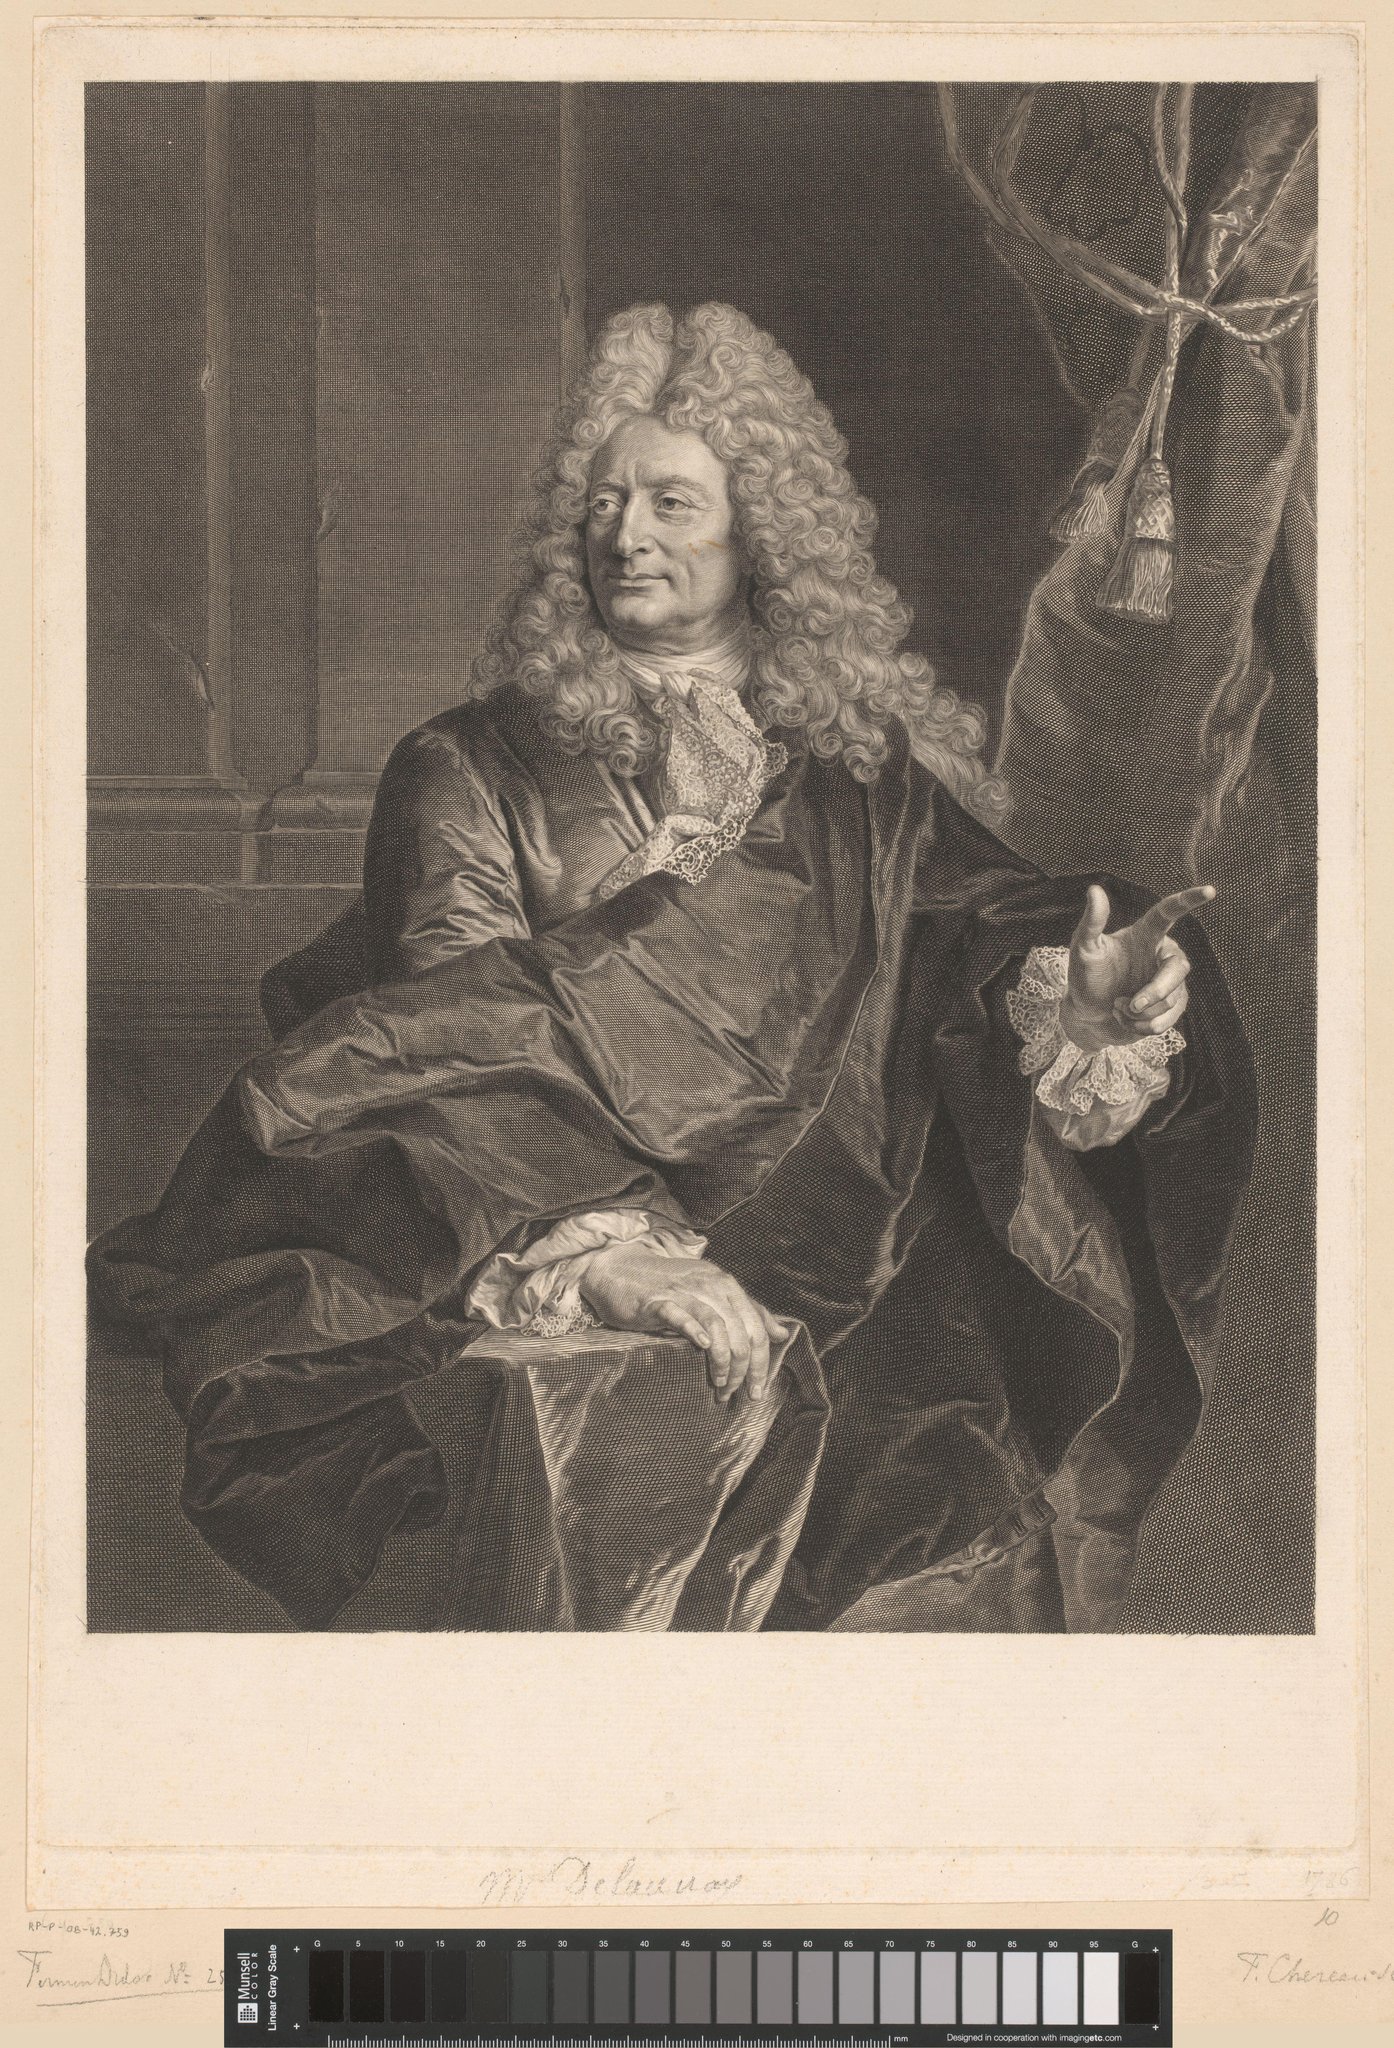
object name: print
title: Portret van Nicolas de Launay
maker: françois chéreau (i)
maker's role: print maker, publisher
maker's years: 1680-1729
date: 1719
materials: paper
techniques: engraving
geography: france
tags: goldsmith, sculptor, nicolas de launay (goudsmid), curtains, historical persons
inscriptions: collector's mark: Lugt 240